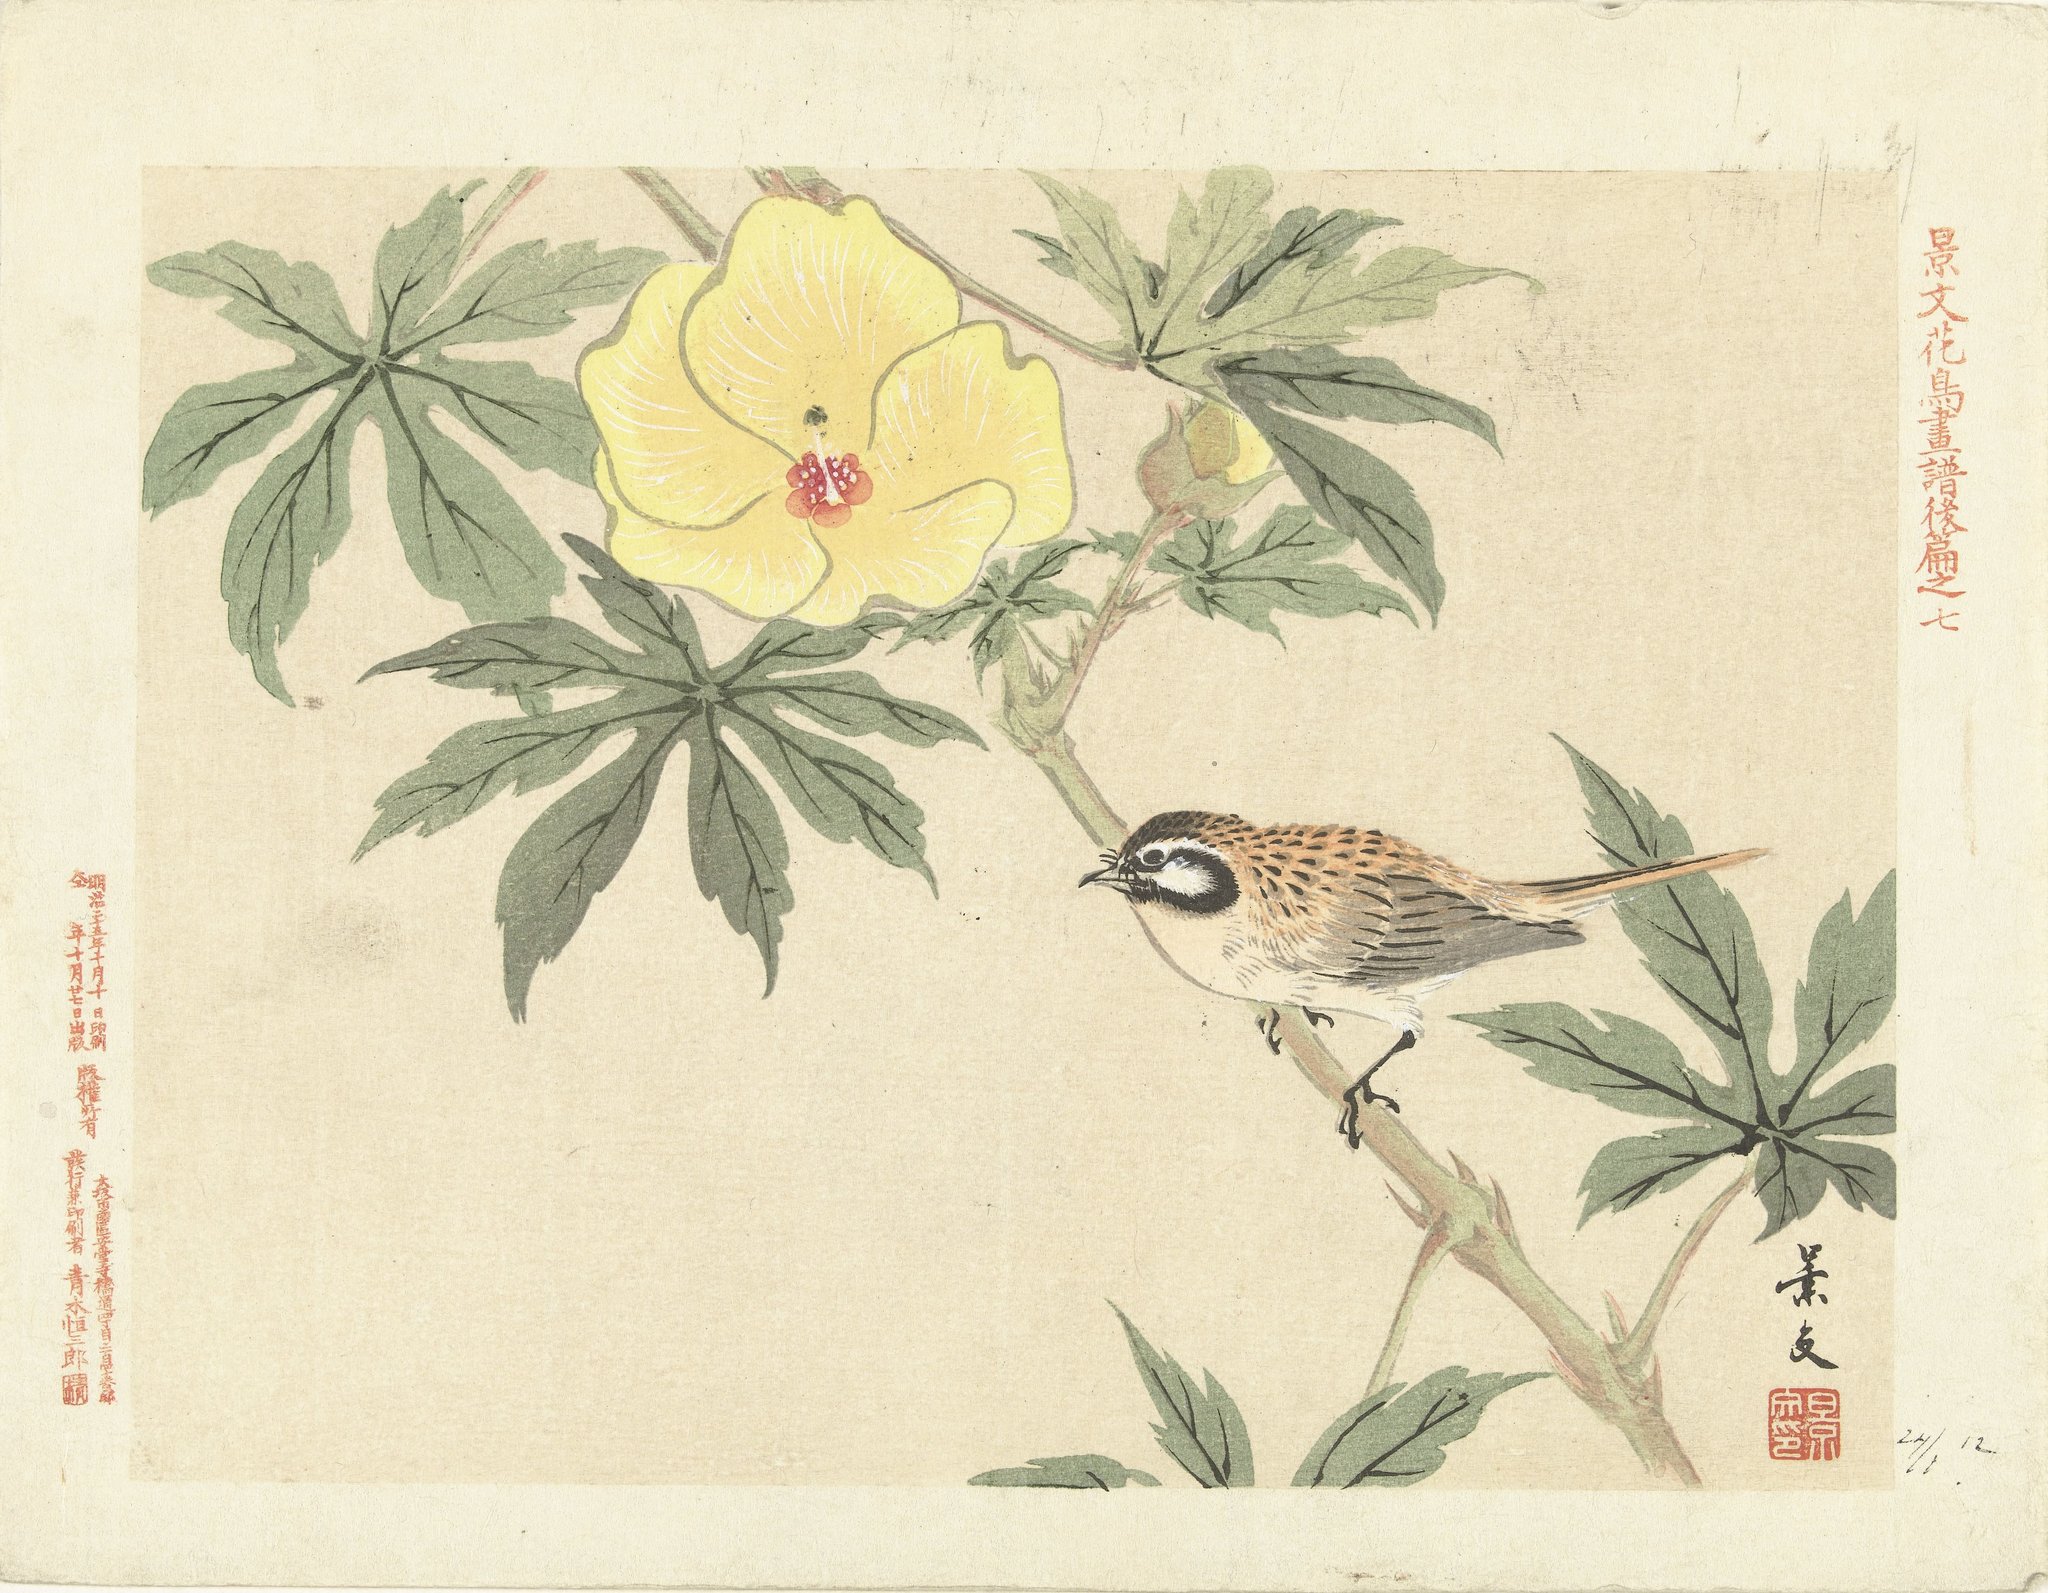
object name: print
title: Keibun kacho gafu kohen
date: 1810-1892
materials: paper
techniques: woodcut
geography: osaka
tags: plants; vegetation, birds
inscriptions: collector's mark: ‘Rijksschool voor kunstnijverheid’ Lugt 3937, collector's mark: Lugt 2228